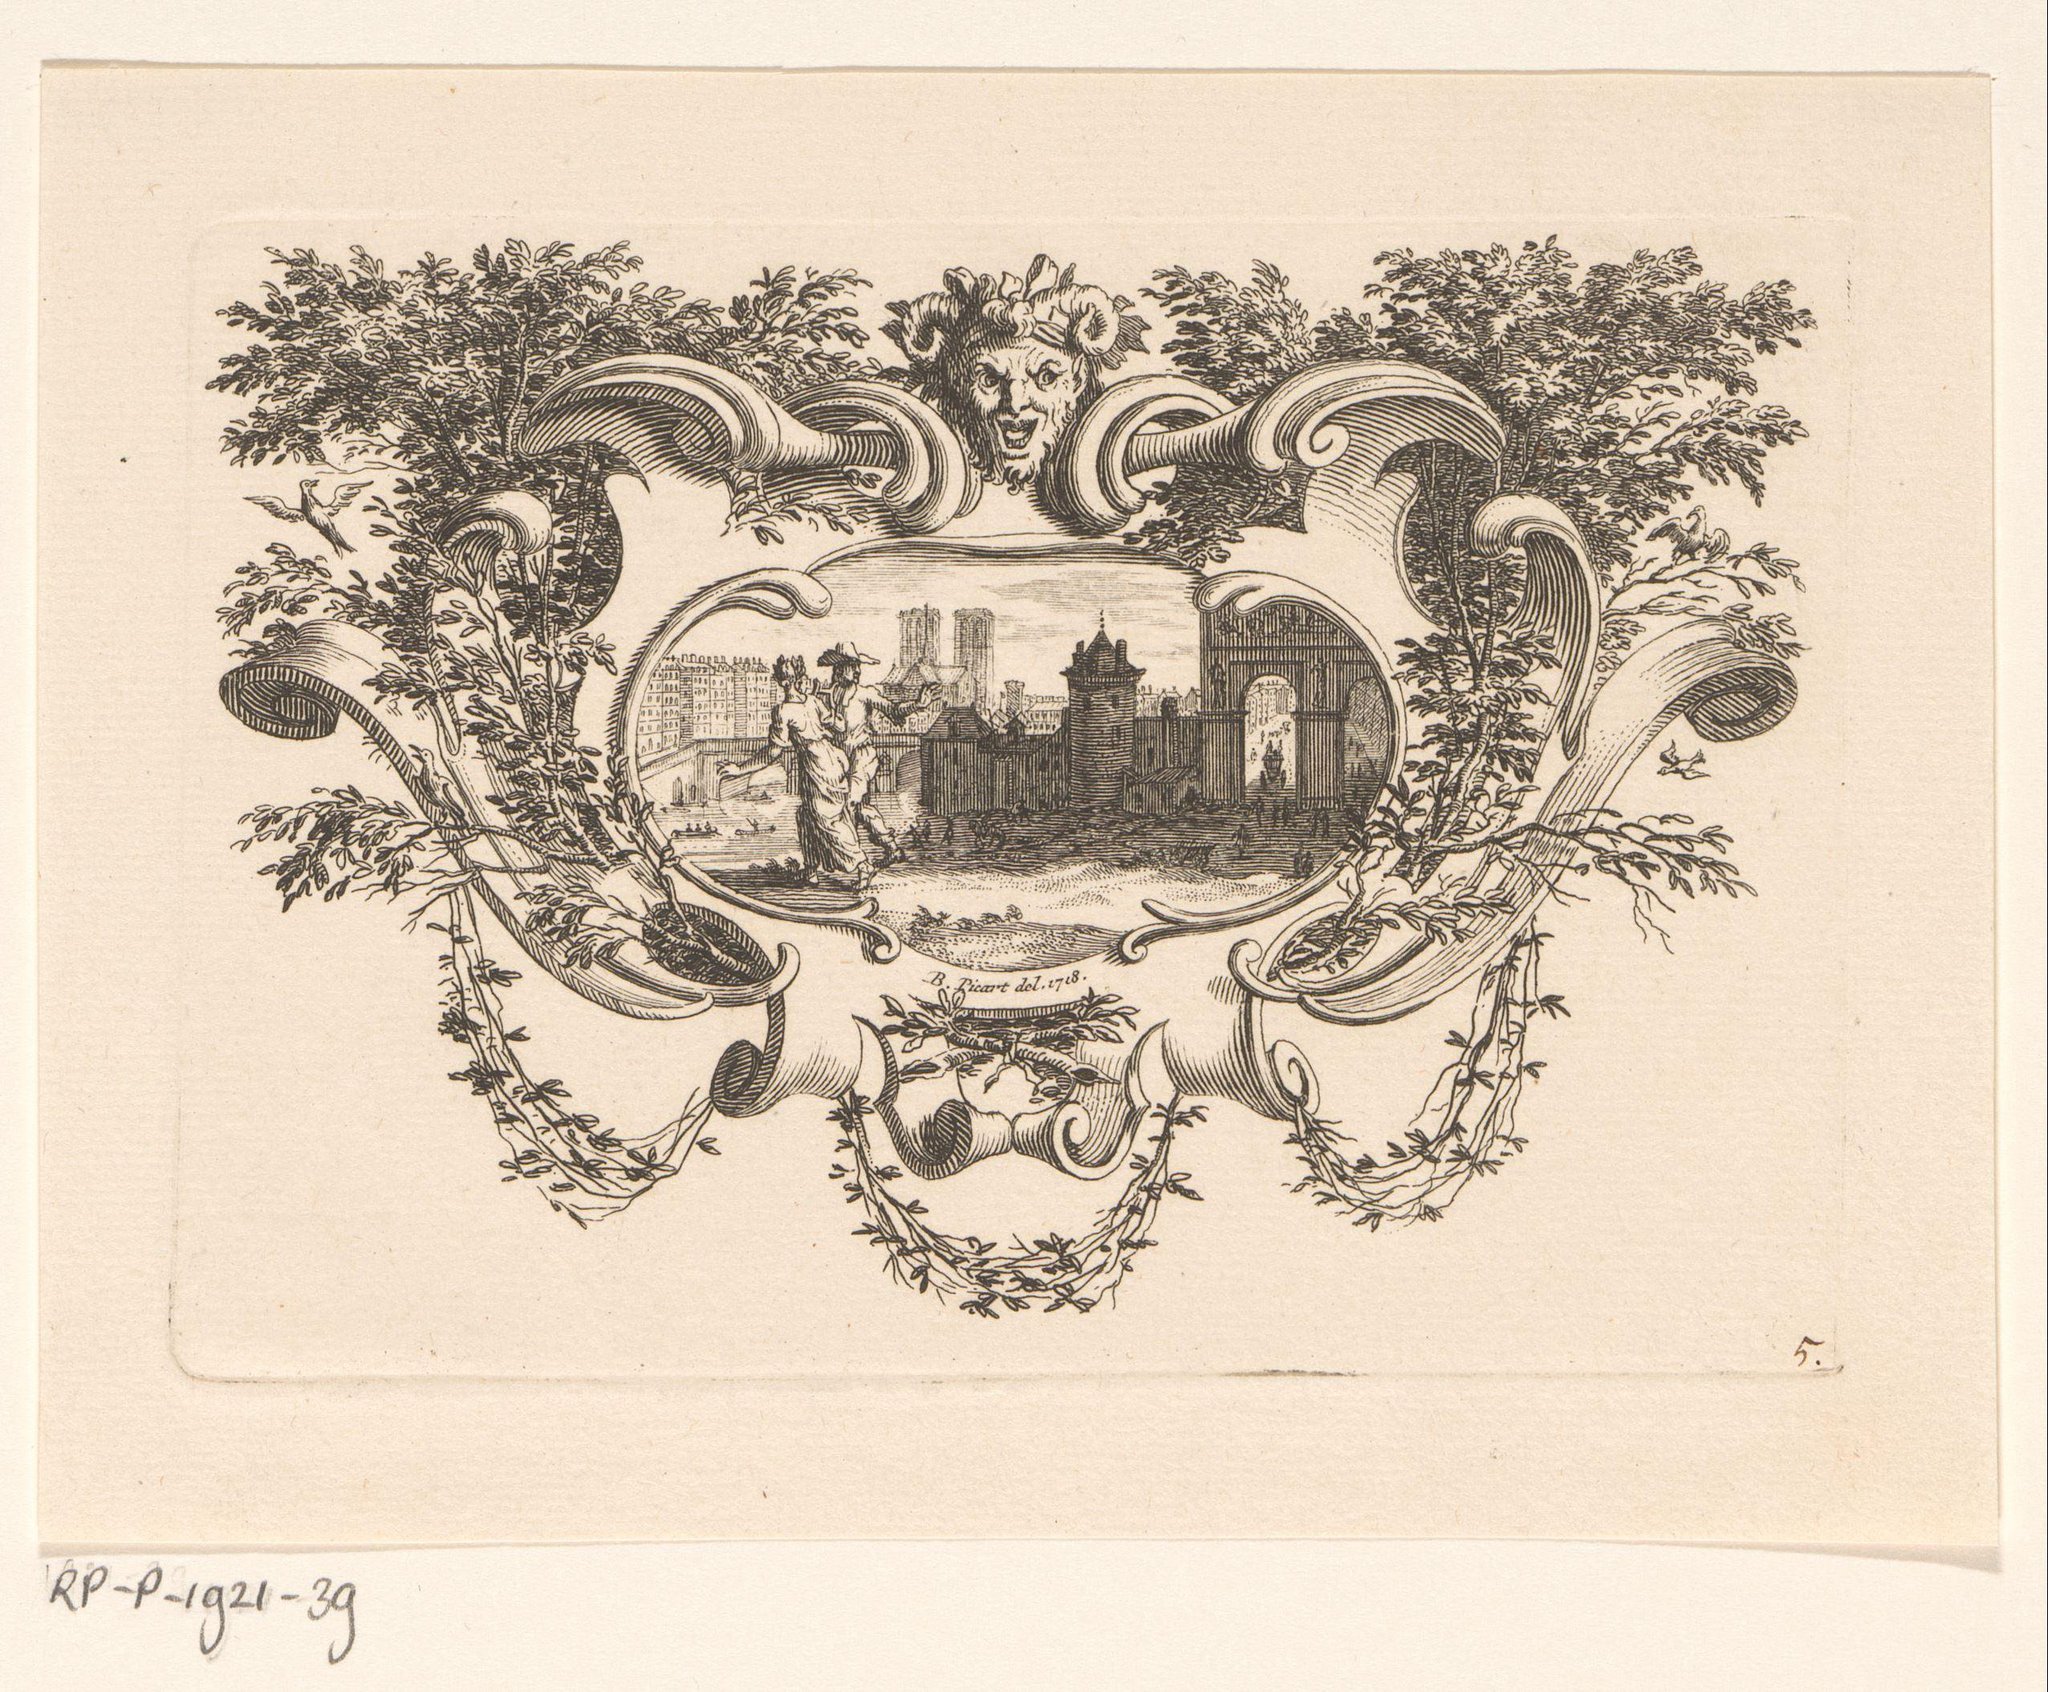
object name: print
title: Schrijver en zijn muze bij Parijs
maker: bernard picart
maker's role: draughtsman, print maker, publisher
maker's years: 1673-1733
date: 1718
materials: paper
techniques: engraving, etching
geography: amsterdam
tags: ornaments ~ art, (story of the) muses; 'muse' (ripa), writer, poet, author, paris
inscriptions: collector's mark: Lugt 2233, number: ‘5.’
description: Ornamenteel cartouche met een voorstelling van de stad Parijs en een schrijver, vermoedelijk Nicolas Boileau-Despréaux, die met zijn muze de stad verlaat.